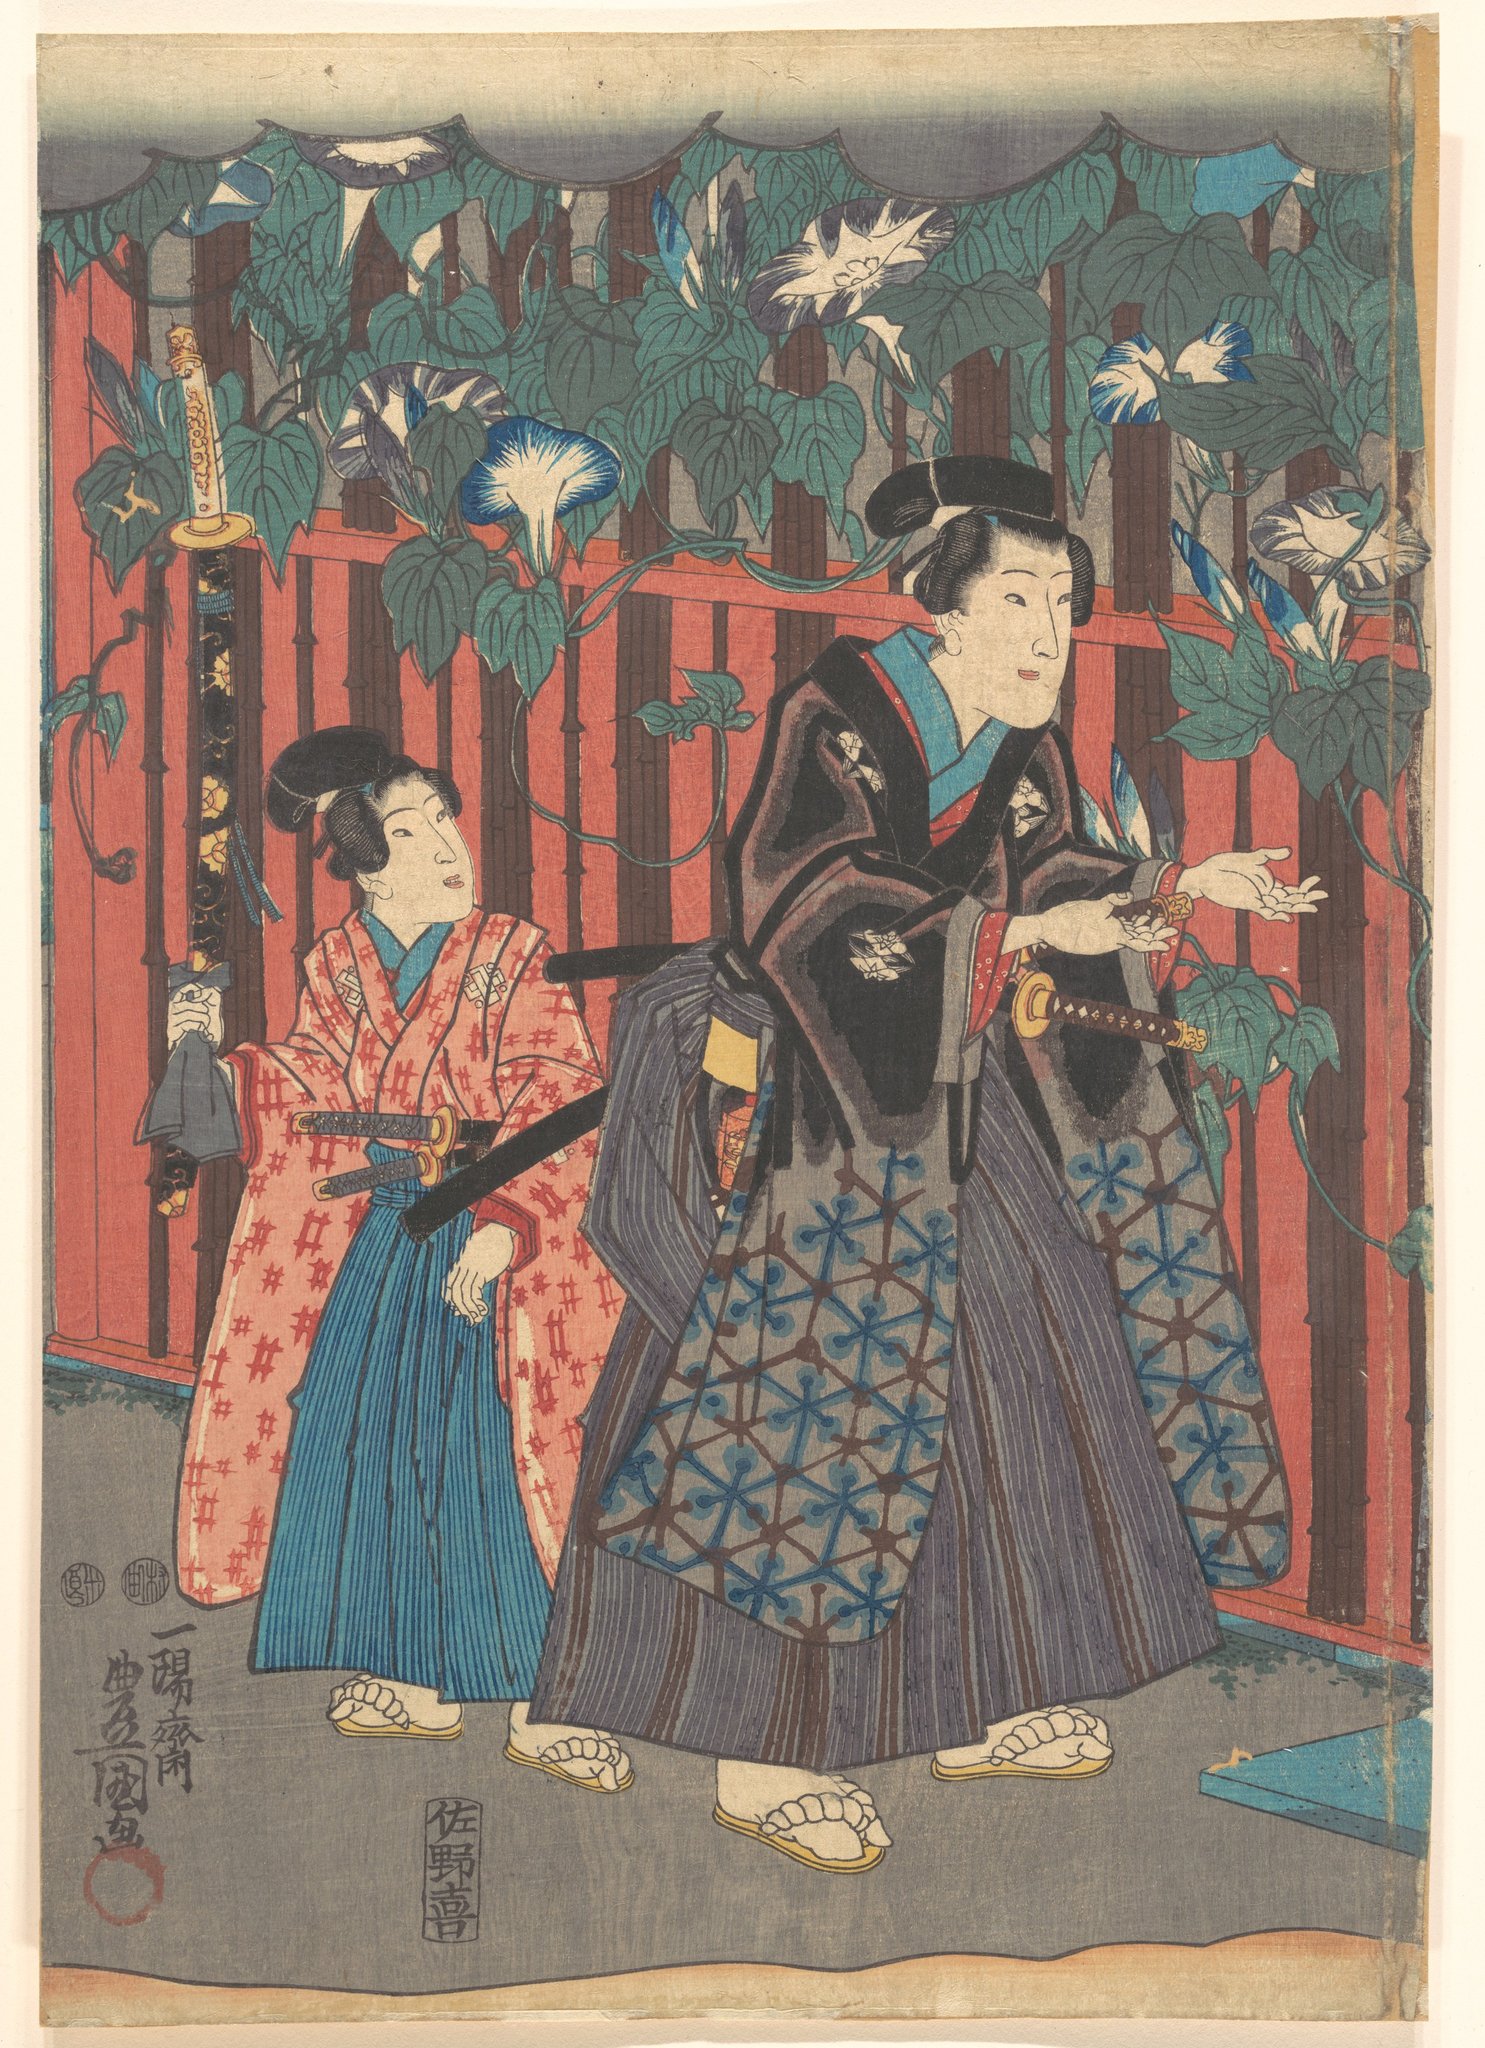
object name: print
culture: japanese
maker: utagawa kunisada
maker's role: artist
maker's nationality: japanese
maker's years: 1786-1864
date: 1786-1854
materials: ink, paper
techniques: woodblock print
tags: girls,women,flowers